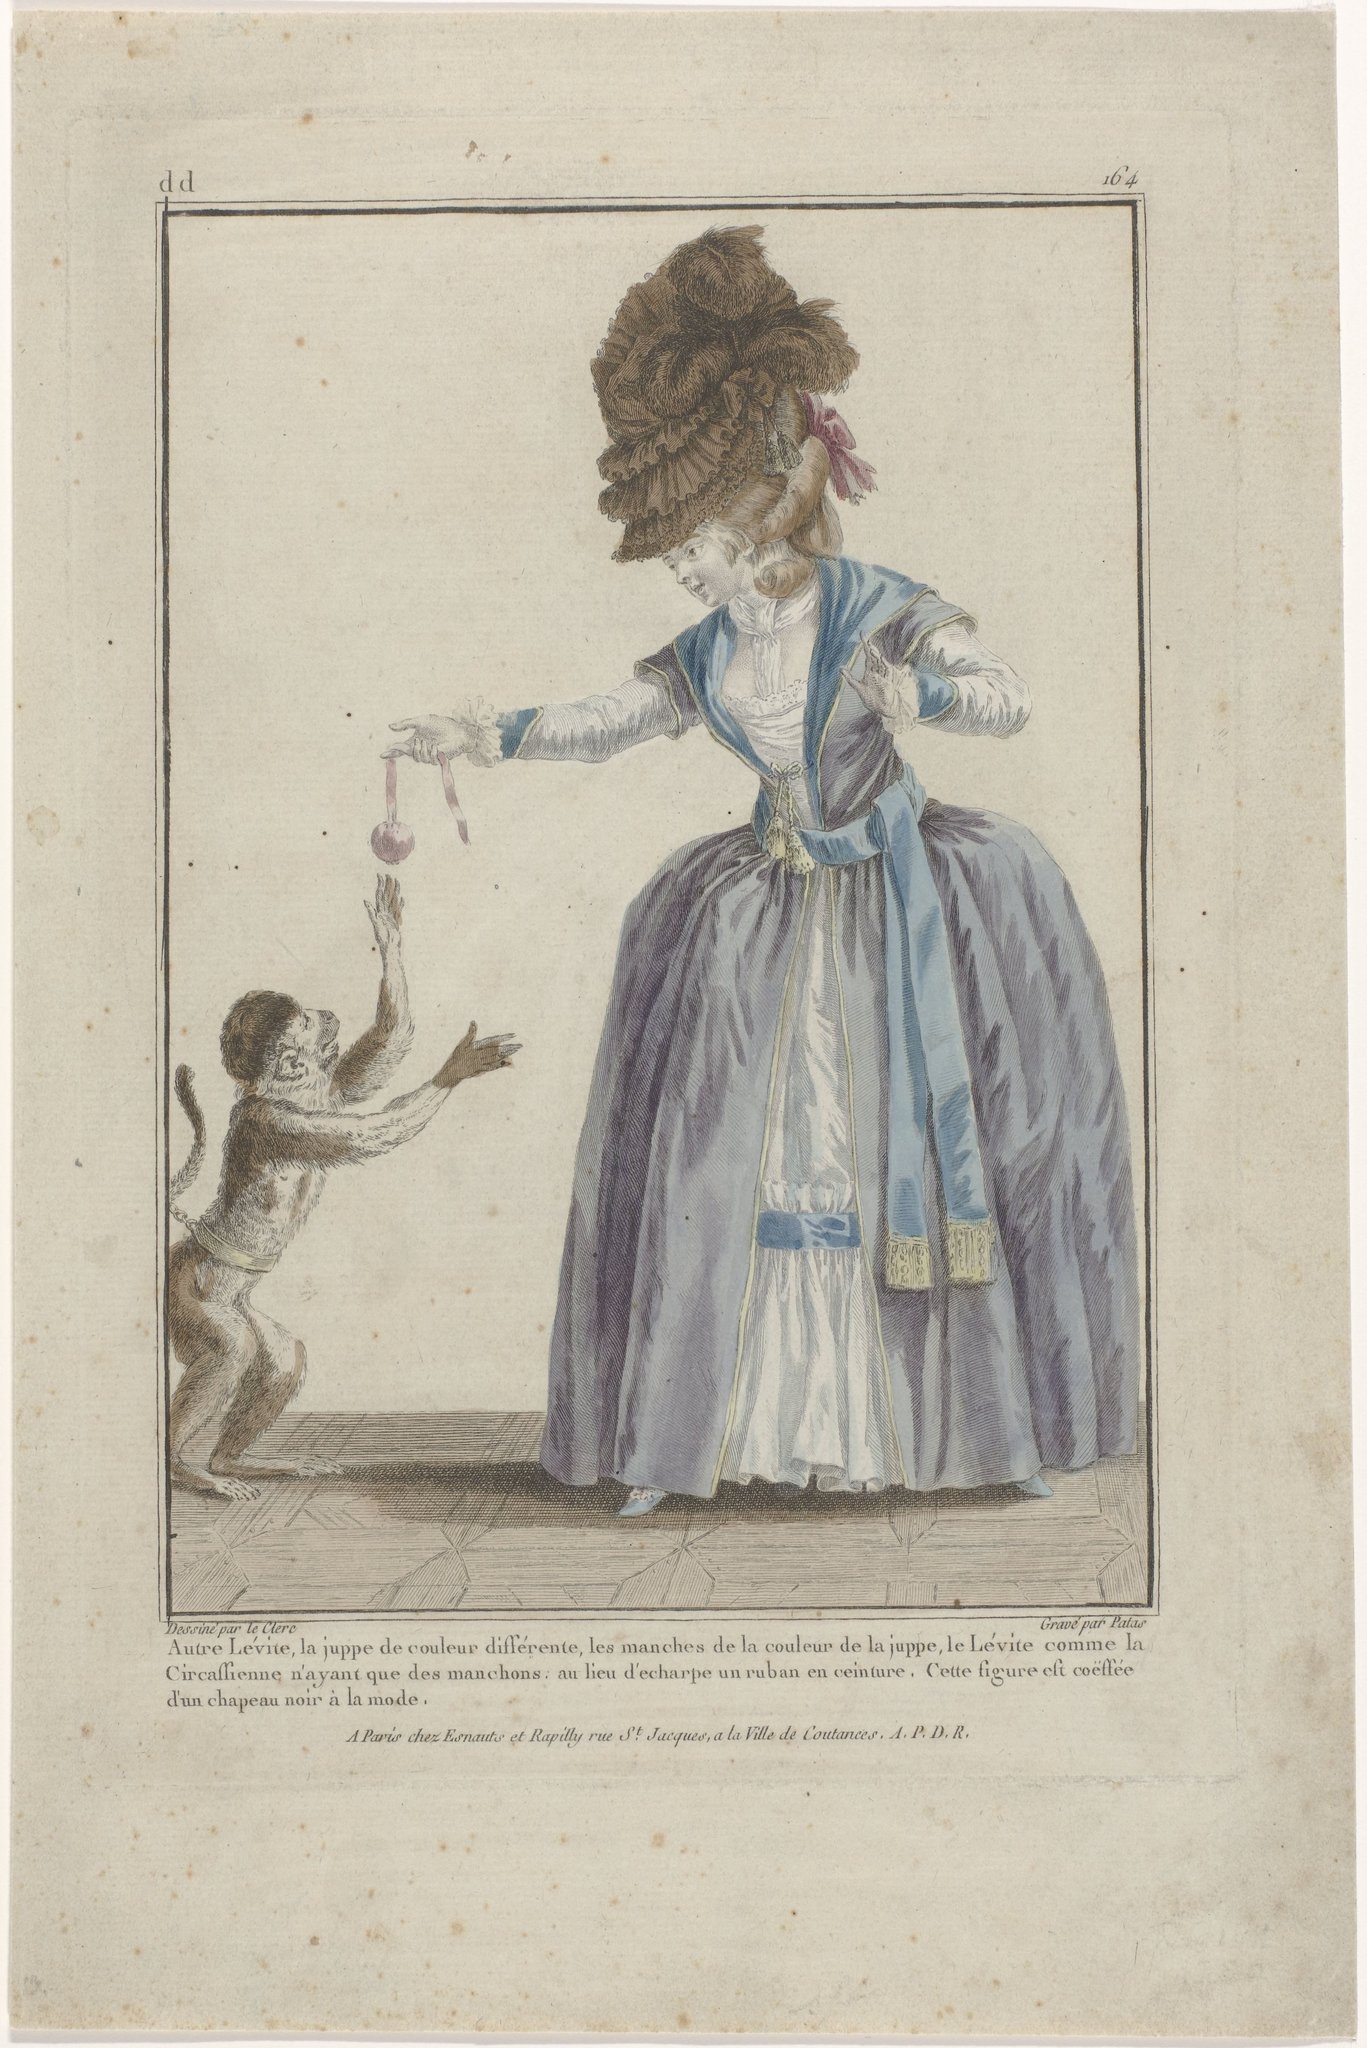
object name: fashion print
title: Gallerie des Modes et Costumes Français, 1780, dd 164 : Autre Lévite, la juppe de couleur différent (...)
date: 1780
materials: paper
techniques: engraving, hand coloring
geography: paris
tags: clothing for the upper part of the body (shawl) (+ women's clothes), ornamental parts of clothing (+ women's clothes), monkeys, apes, dress, gown: robe à la lévite (+ women's clothes), fashion plates, head-gear: hat (+ women's clothes), skirt (+ women's clothes), neck-gear ~ clothing (+ women's clothes), belt, girdle, waistband (+ women's clothes)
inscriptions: address: ‘A Paris chez Esnauts et Rapilly, rue St. Jacques, a la Ville de Coutances. A.P.D.R.’, caption: ‘Autre Lévite, la juppe de couleur différente, les manches de la couleur de la juppe, le Lévite comme la Circassienne n'ayant que des manchons: au lieu d'echarpe un ruban en ceinture. Cette figure est coëffée d'un chapeau noir à la mode.’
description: Vrouw met in de rechterhand een bal aan een lint, spelend met een aapje aan een ketting. Zij draagt een 'Lévite' (jasjurk) met een rok in een contrasterende kleur; de mouwen in dezelfde kleur als de rok. De 'Lévite' heeft net zoals de 'Circassienne' alleen manchetten(?) en in plaats van een sjaal een lint als ceintuur. Op het hoofd een zwarte hoed volgens de laatste mode. Verdere accessoires: geknoopte halsdoek, schoenen. Prent uit de serie dd. 28e Cahier de Costumes Français, 22e Suite d'Habillemens à la mode en 1780, Gallerie des Modes et Costumes Français.